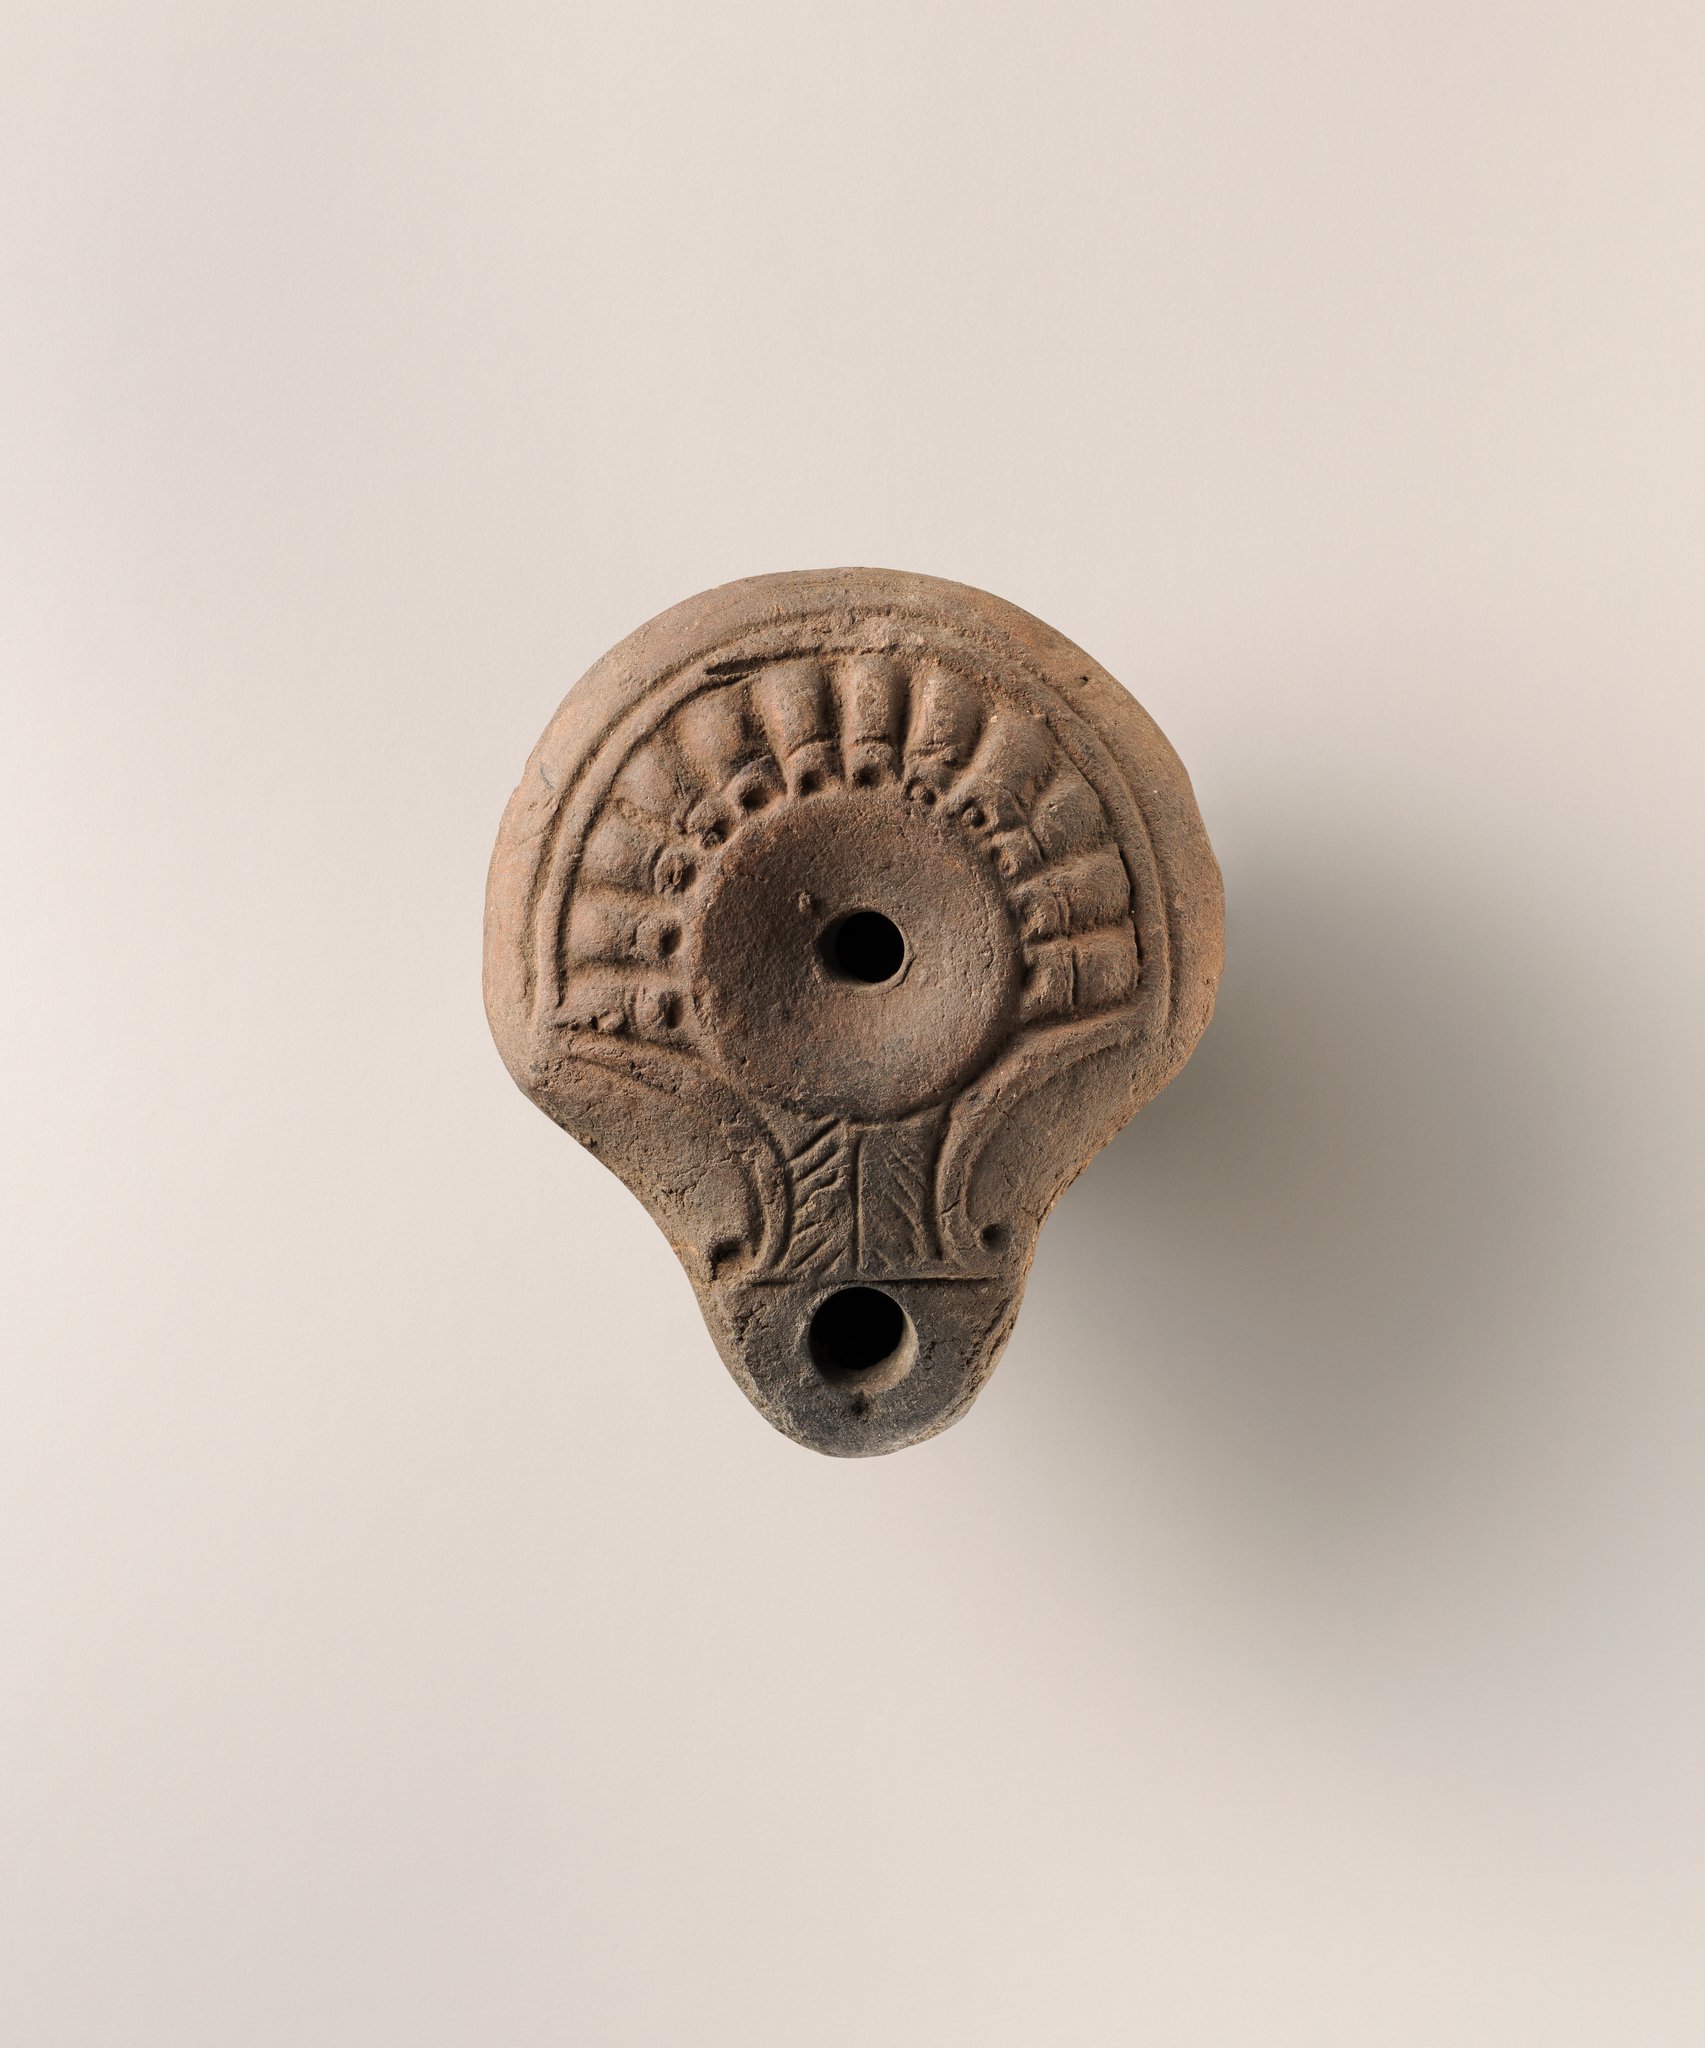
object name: lamp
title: Terracotta oil lamp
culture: roman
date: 101-233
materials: terracotta